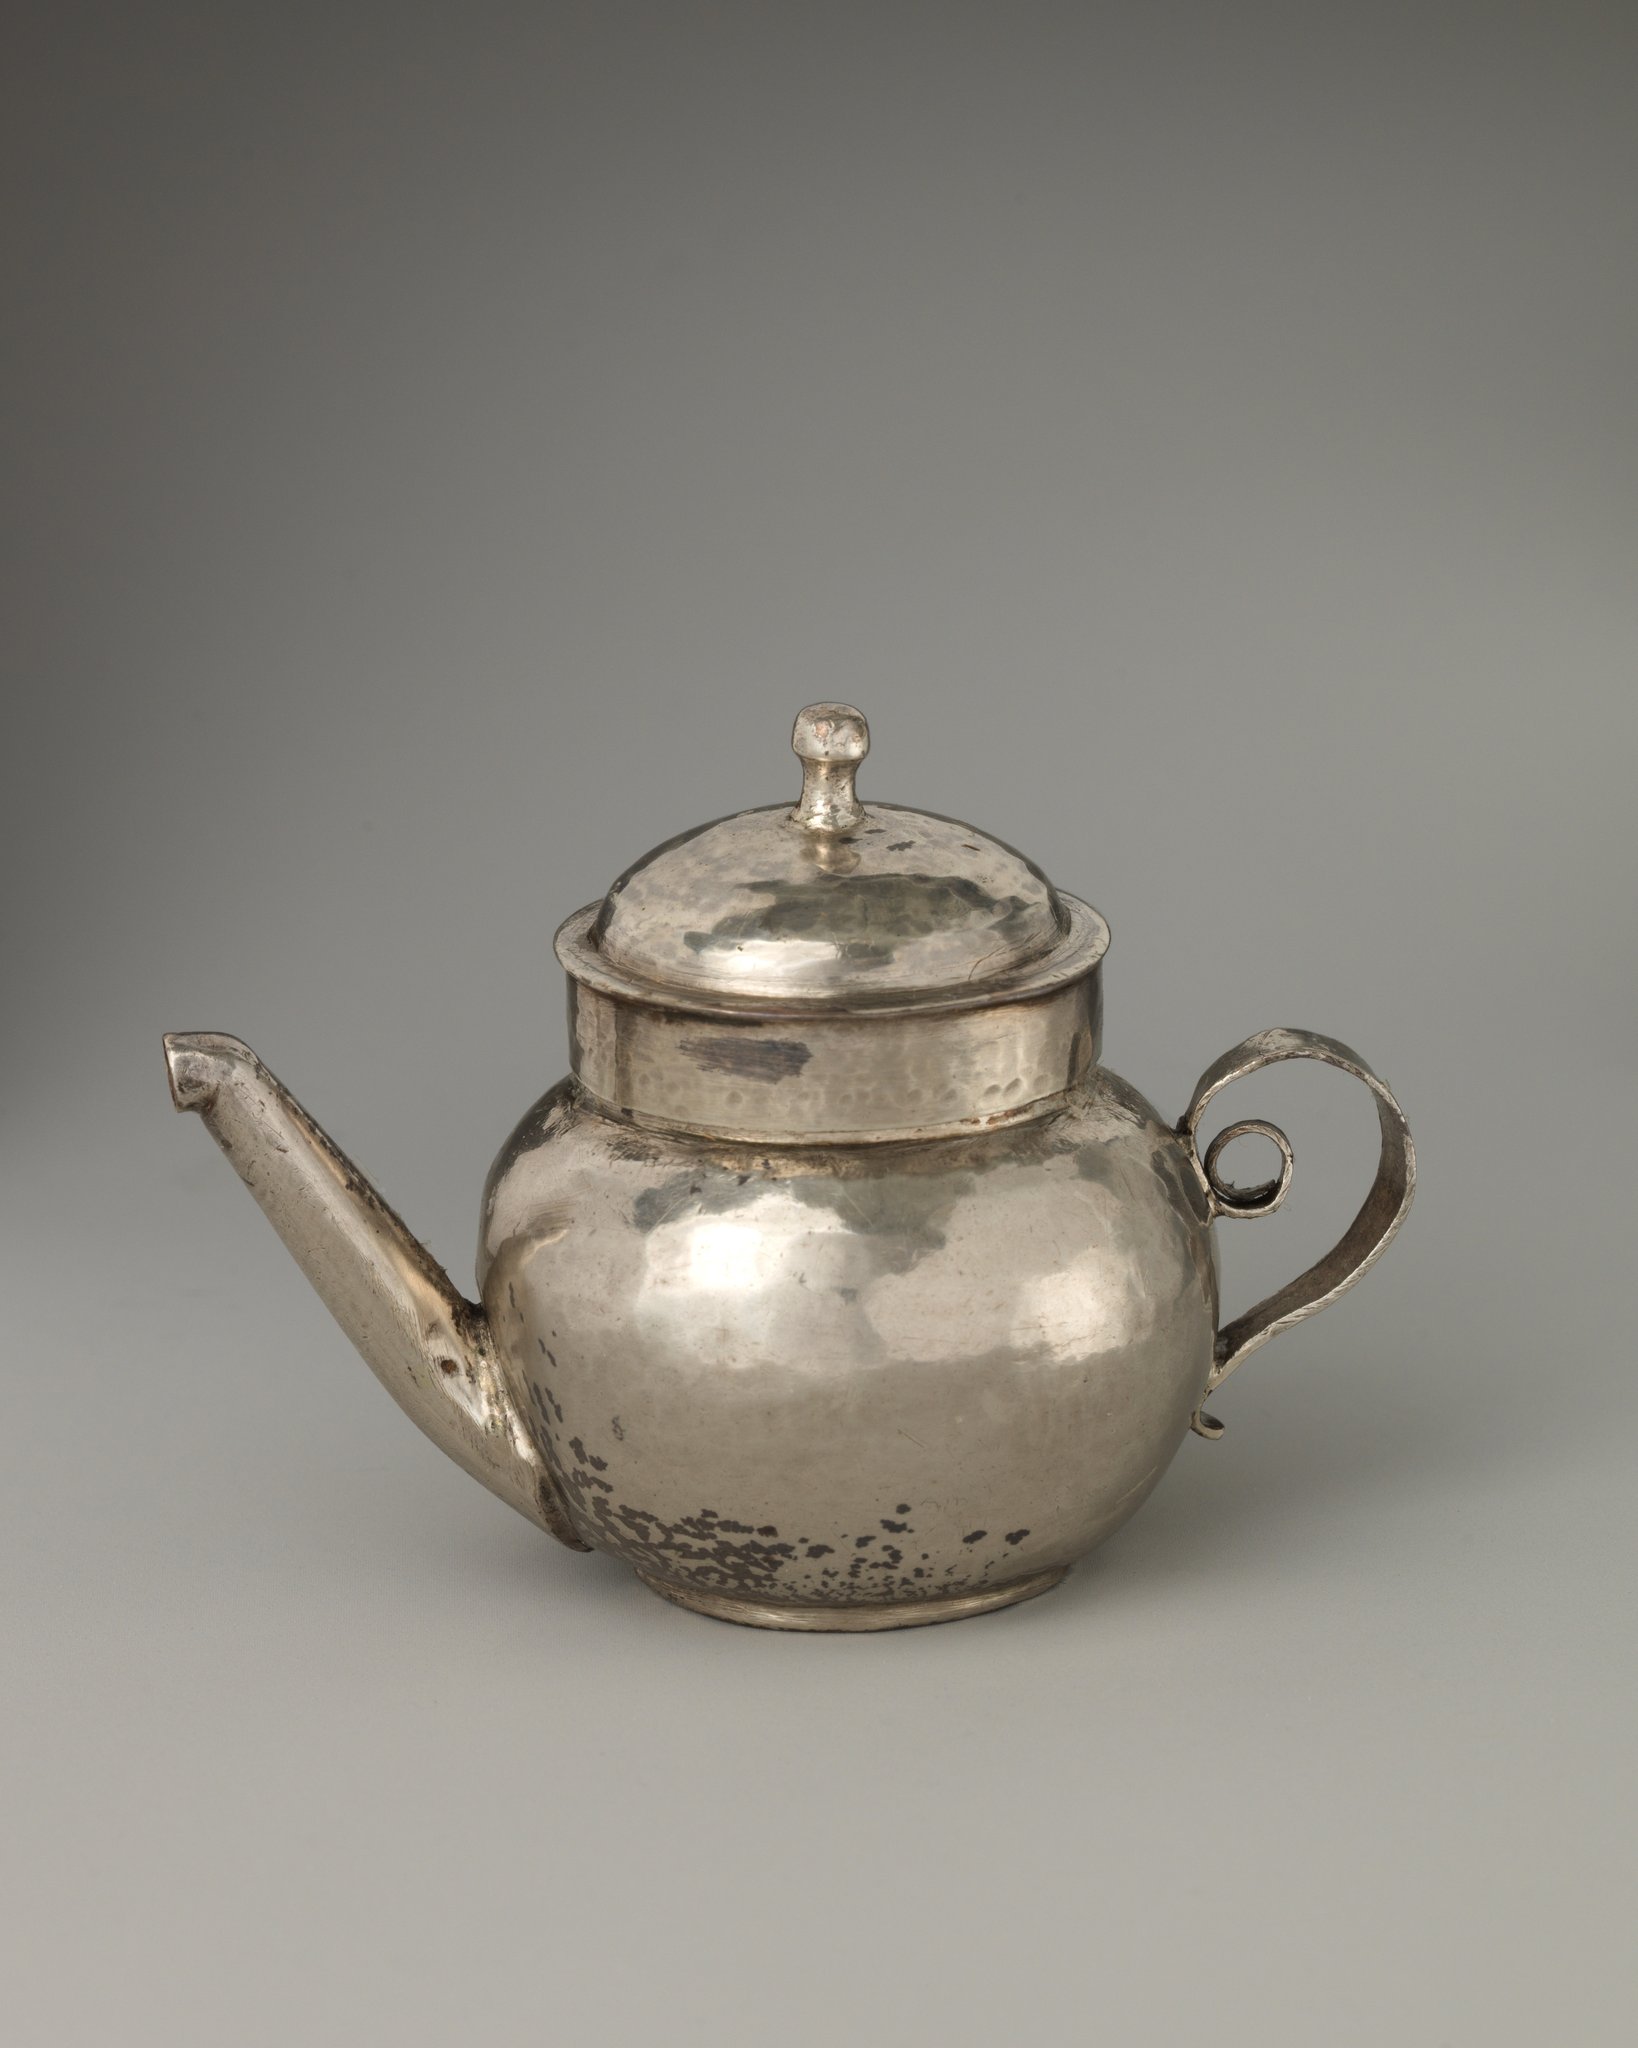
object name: teapot with cover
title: Miniature teapot with cover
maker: george manjoy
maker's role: maker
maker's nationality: british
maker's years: 1685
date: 1703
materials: silver